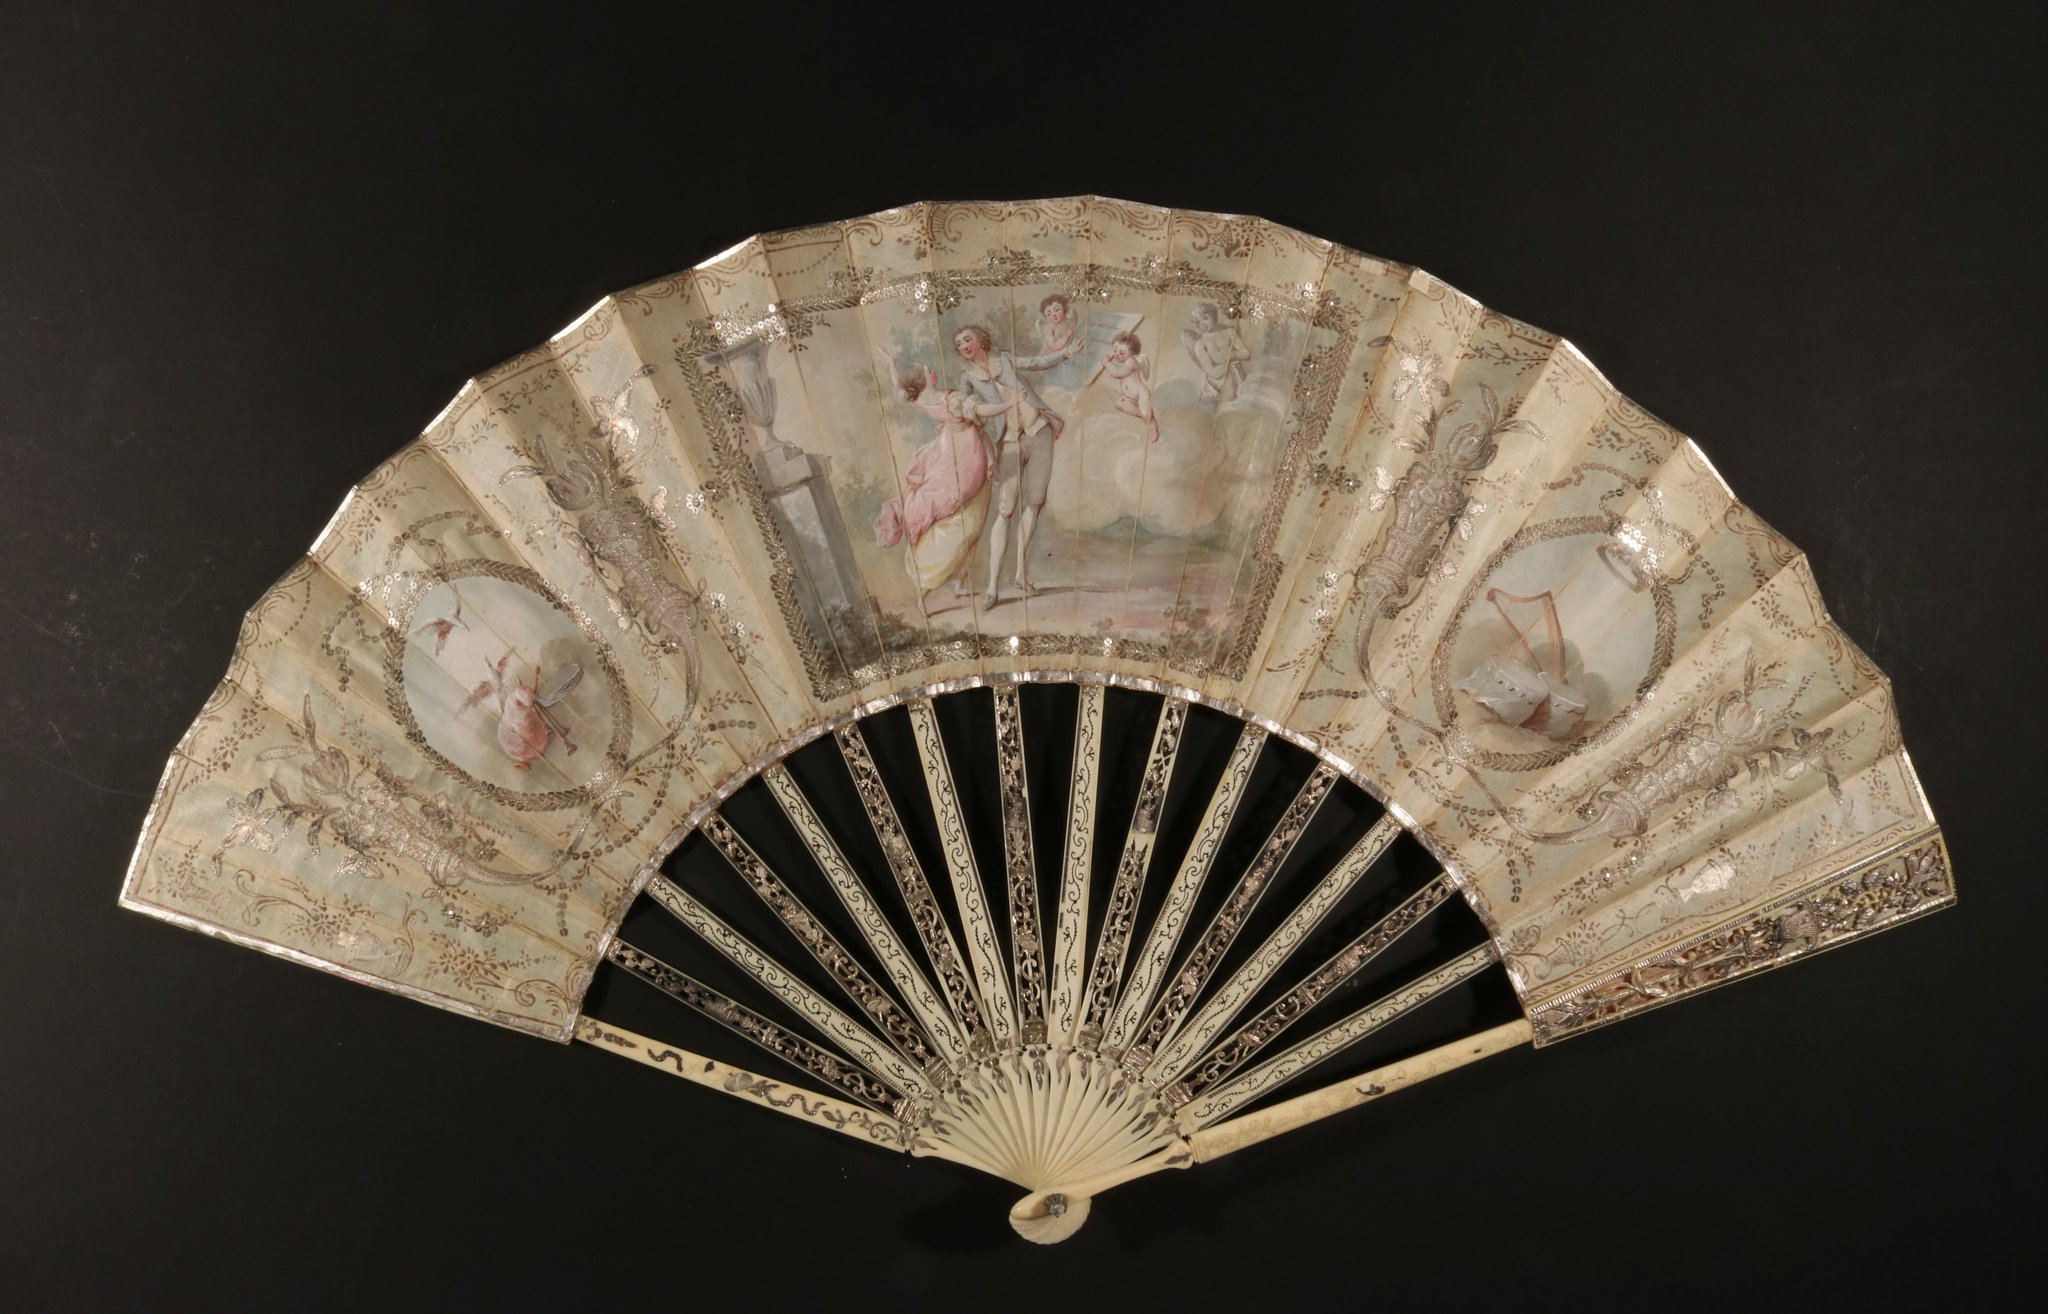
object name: fan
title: The Oath of Love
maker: jean honoré fragonard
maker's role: artist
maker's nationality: french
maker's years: 1732-1806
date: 1867-1900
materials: foil, glass, ivory, mother of pearl, paint, silk, silver, thread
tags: men,women,bagpipes,harps